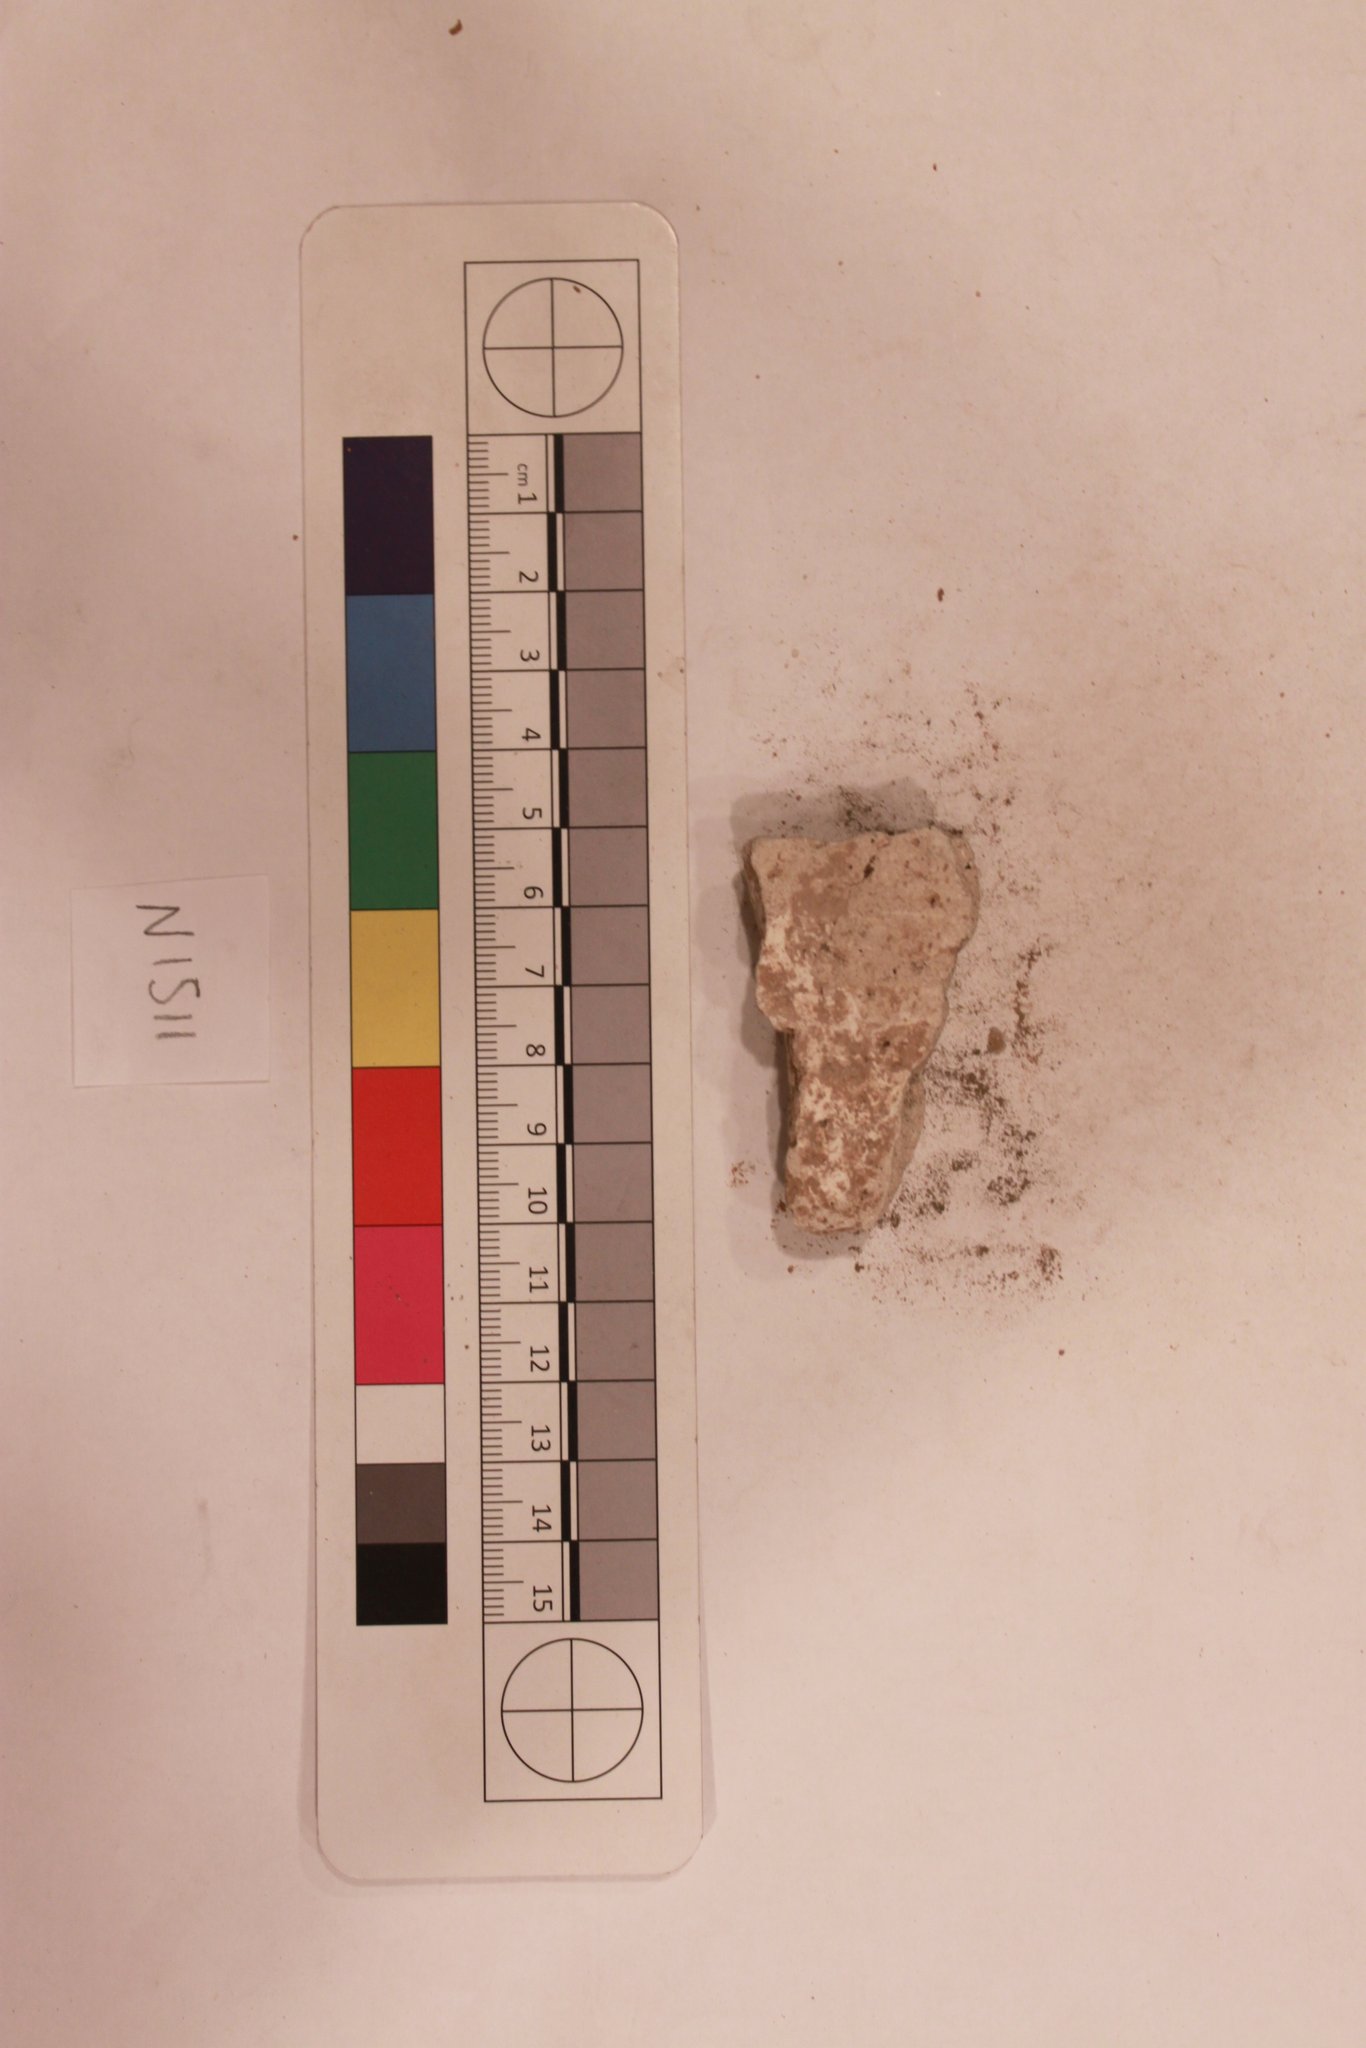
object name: fragment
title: Stucco Fragment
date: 701-1200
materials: plaster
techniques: carving, painting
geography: iran